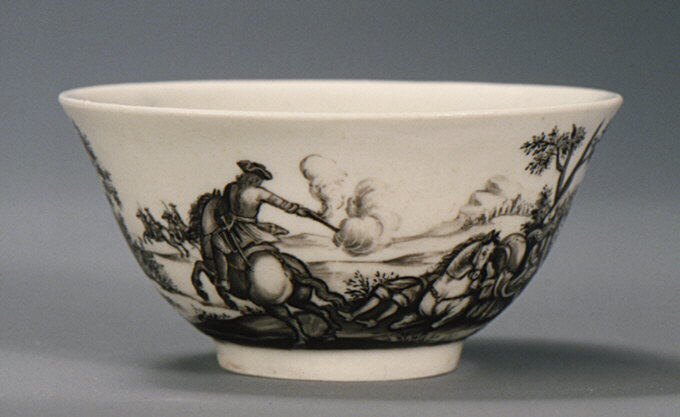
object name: teabowl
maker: meissen manufactory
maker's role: manufactory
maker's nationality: german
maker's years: 1710-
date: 1720-1725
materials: hard paste porcelain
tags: firearms,men,horses